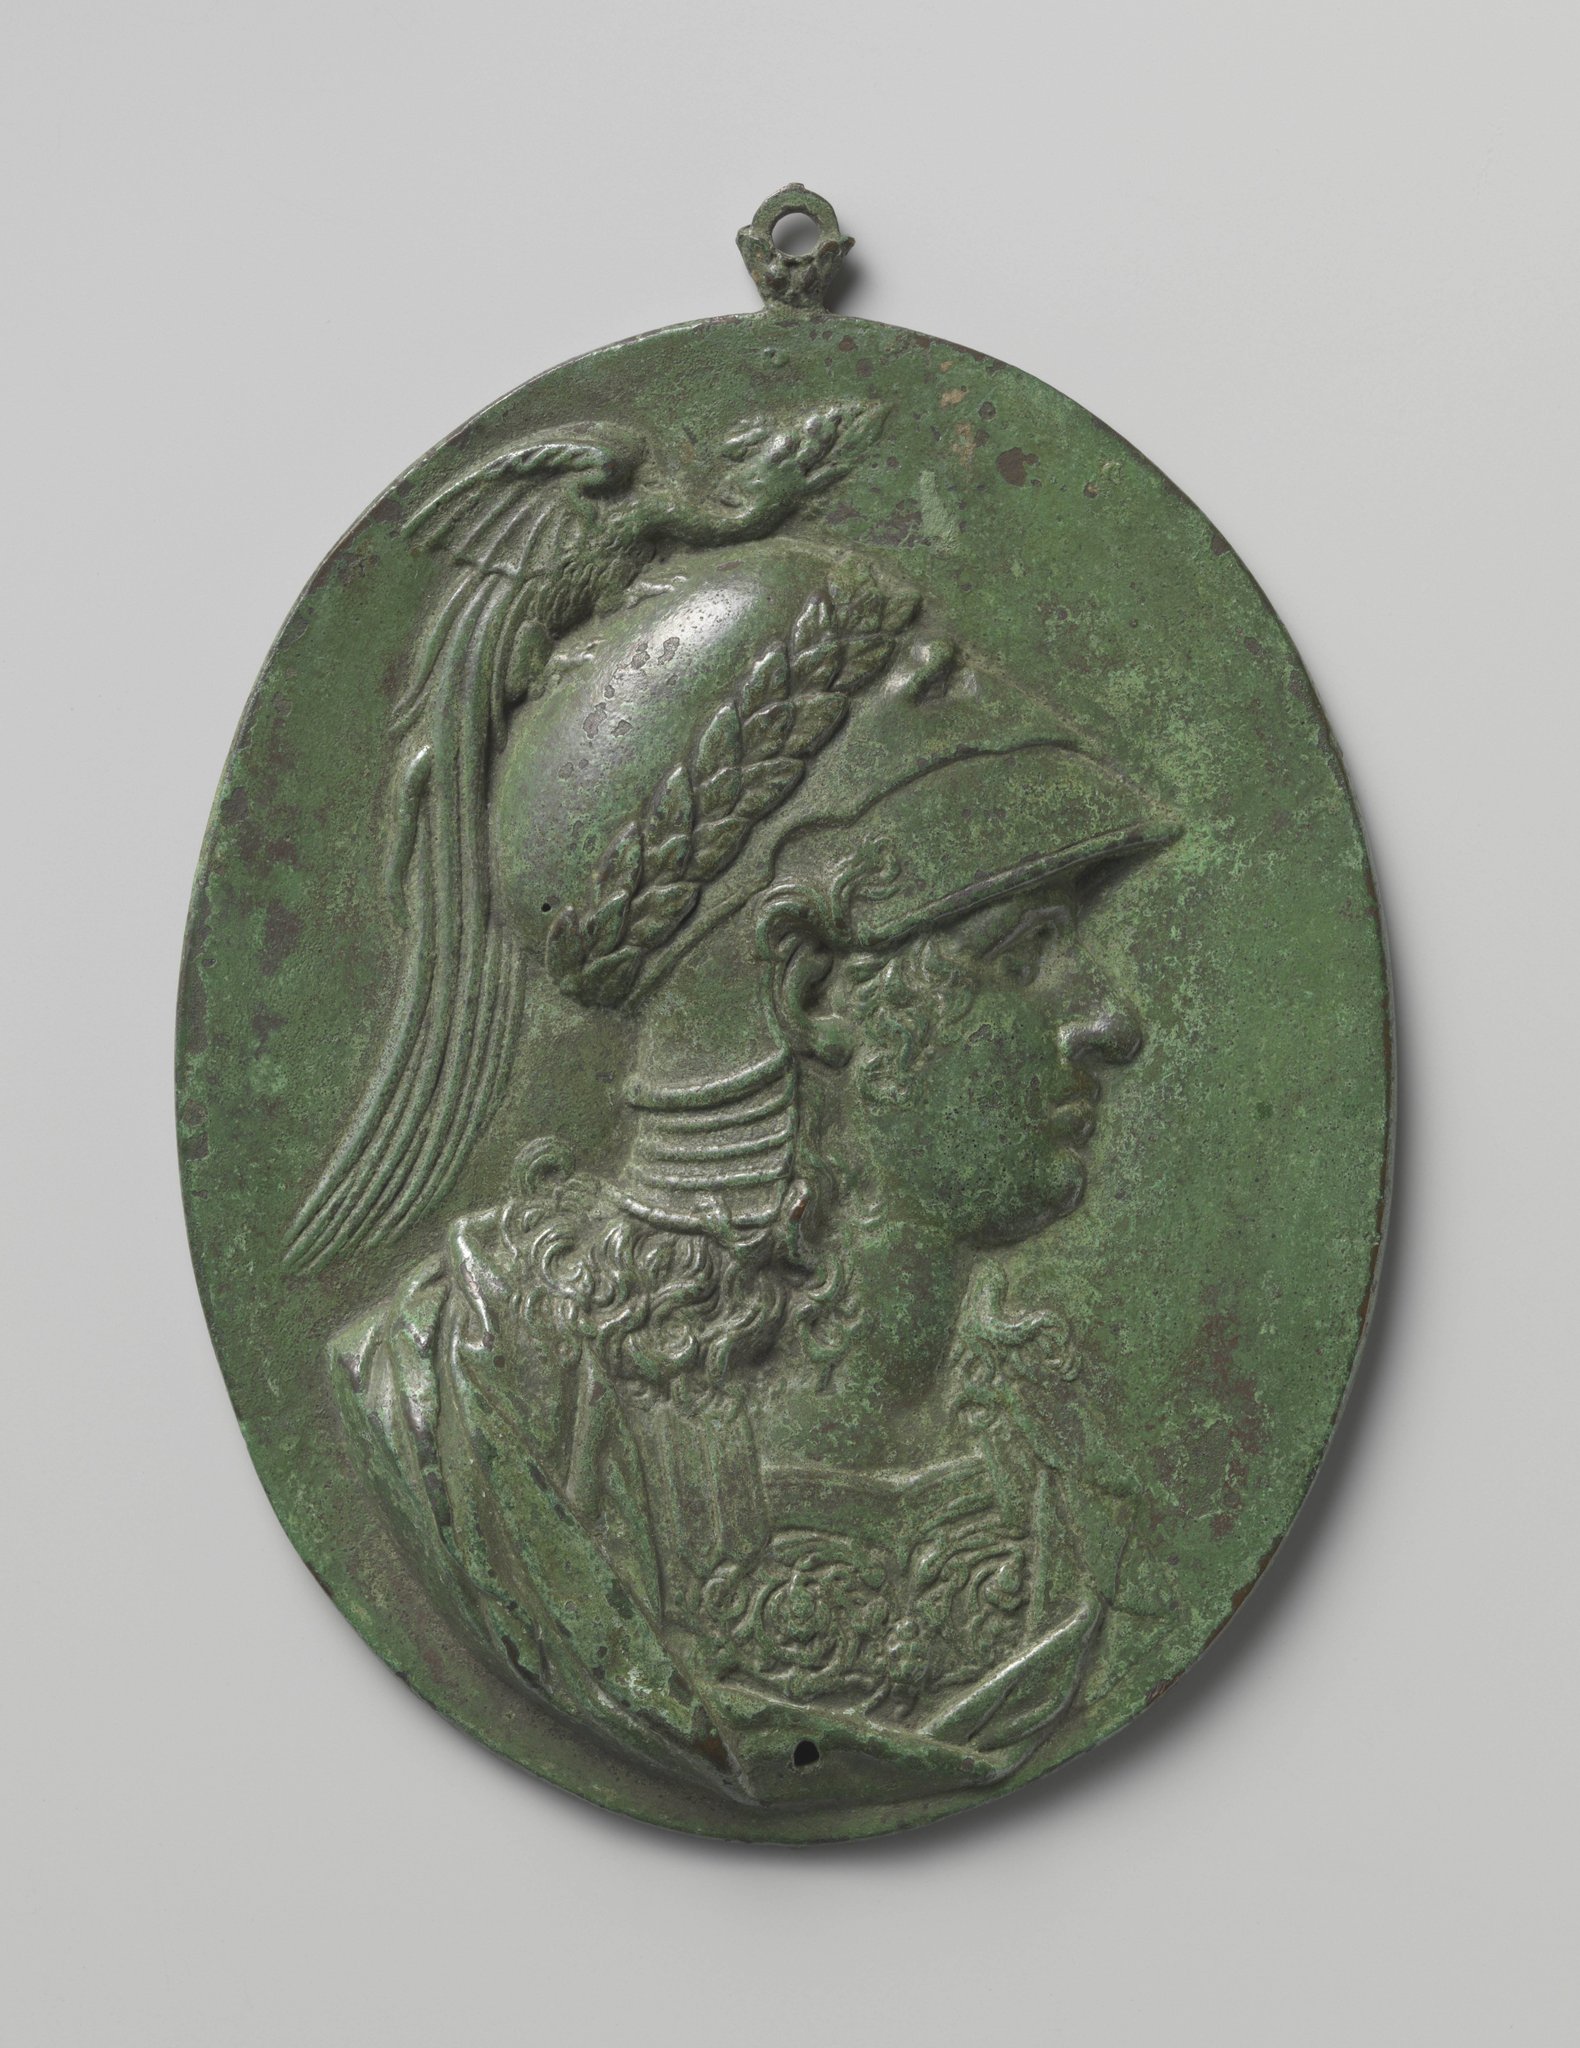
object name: sculpture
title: Medaillonportret van Christina van Zweden (1626-1689)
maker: Anonymous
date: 1700-1800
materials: bronze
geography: france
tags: rome, christina (koningin van zweden)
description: Christina van Zweden in profiel naar rechts, gekleed als Minerva, met gelauwerde helm met draak.